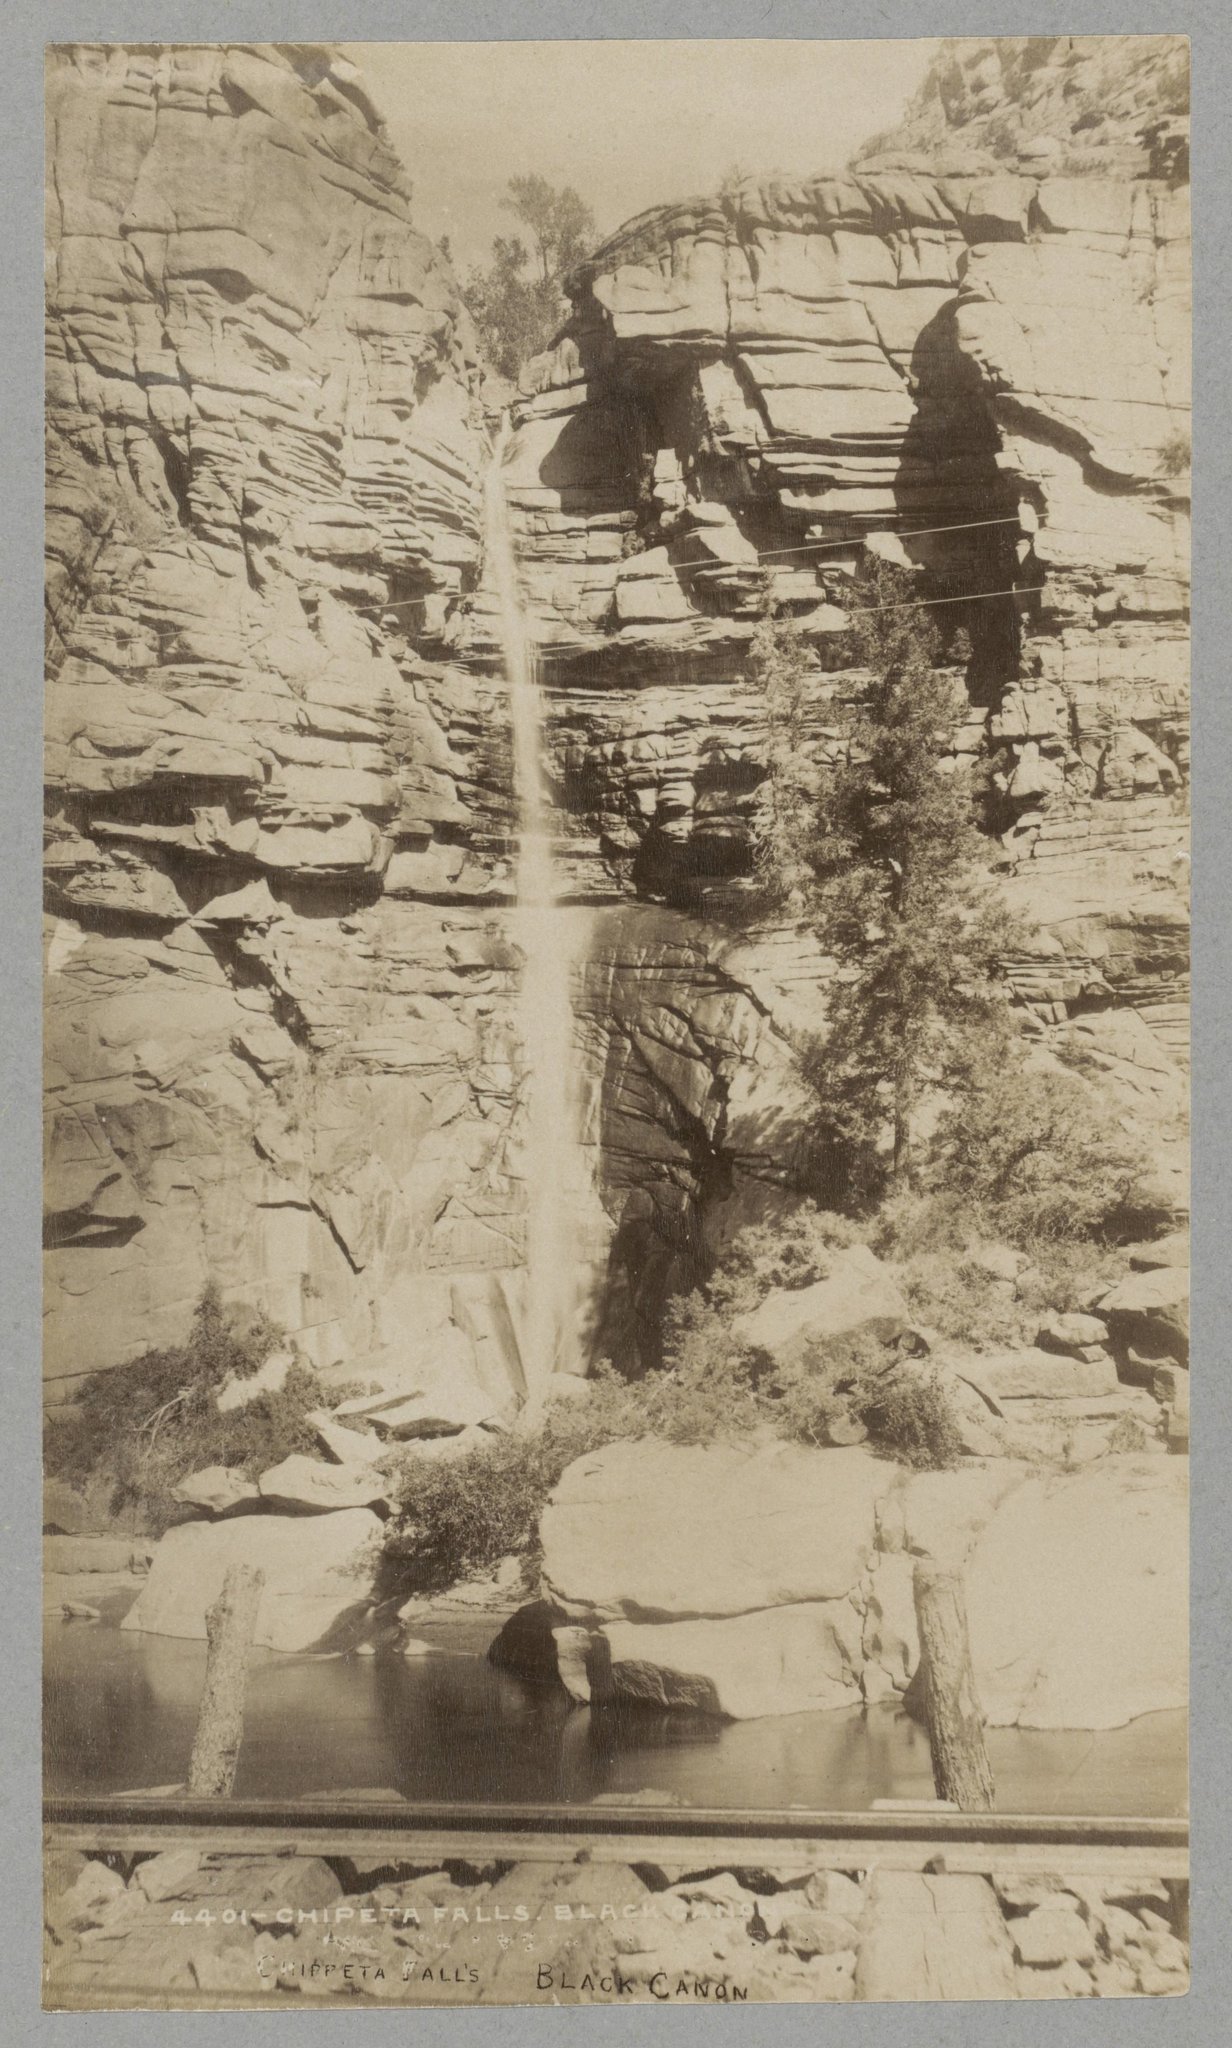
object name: photograph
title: Chipeta Falls. Black Canon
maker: Anonymous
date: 1880-1900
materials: cardboard, paper, photographic support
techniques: albumen print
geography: colorado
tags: waterfall, ravine, chasm, abyss, canyon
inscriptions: negative number: ‘4401’